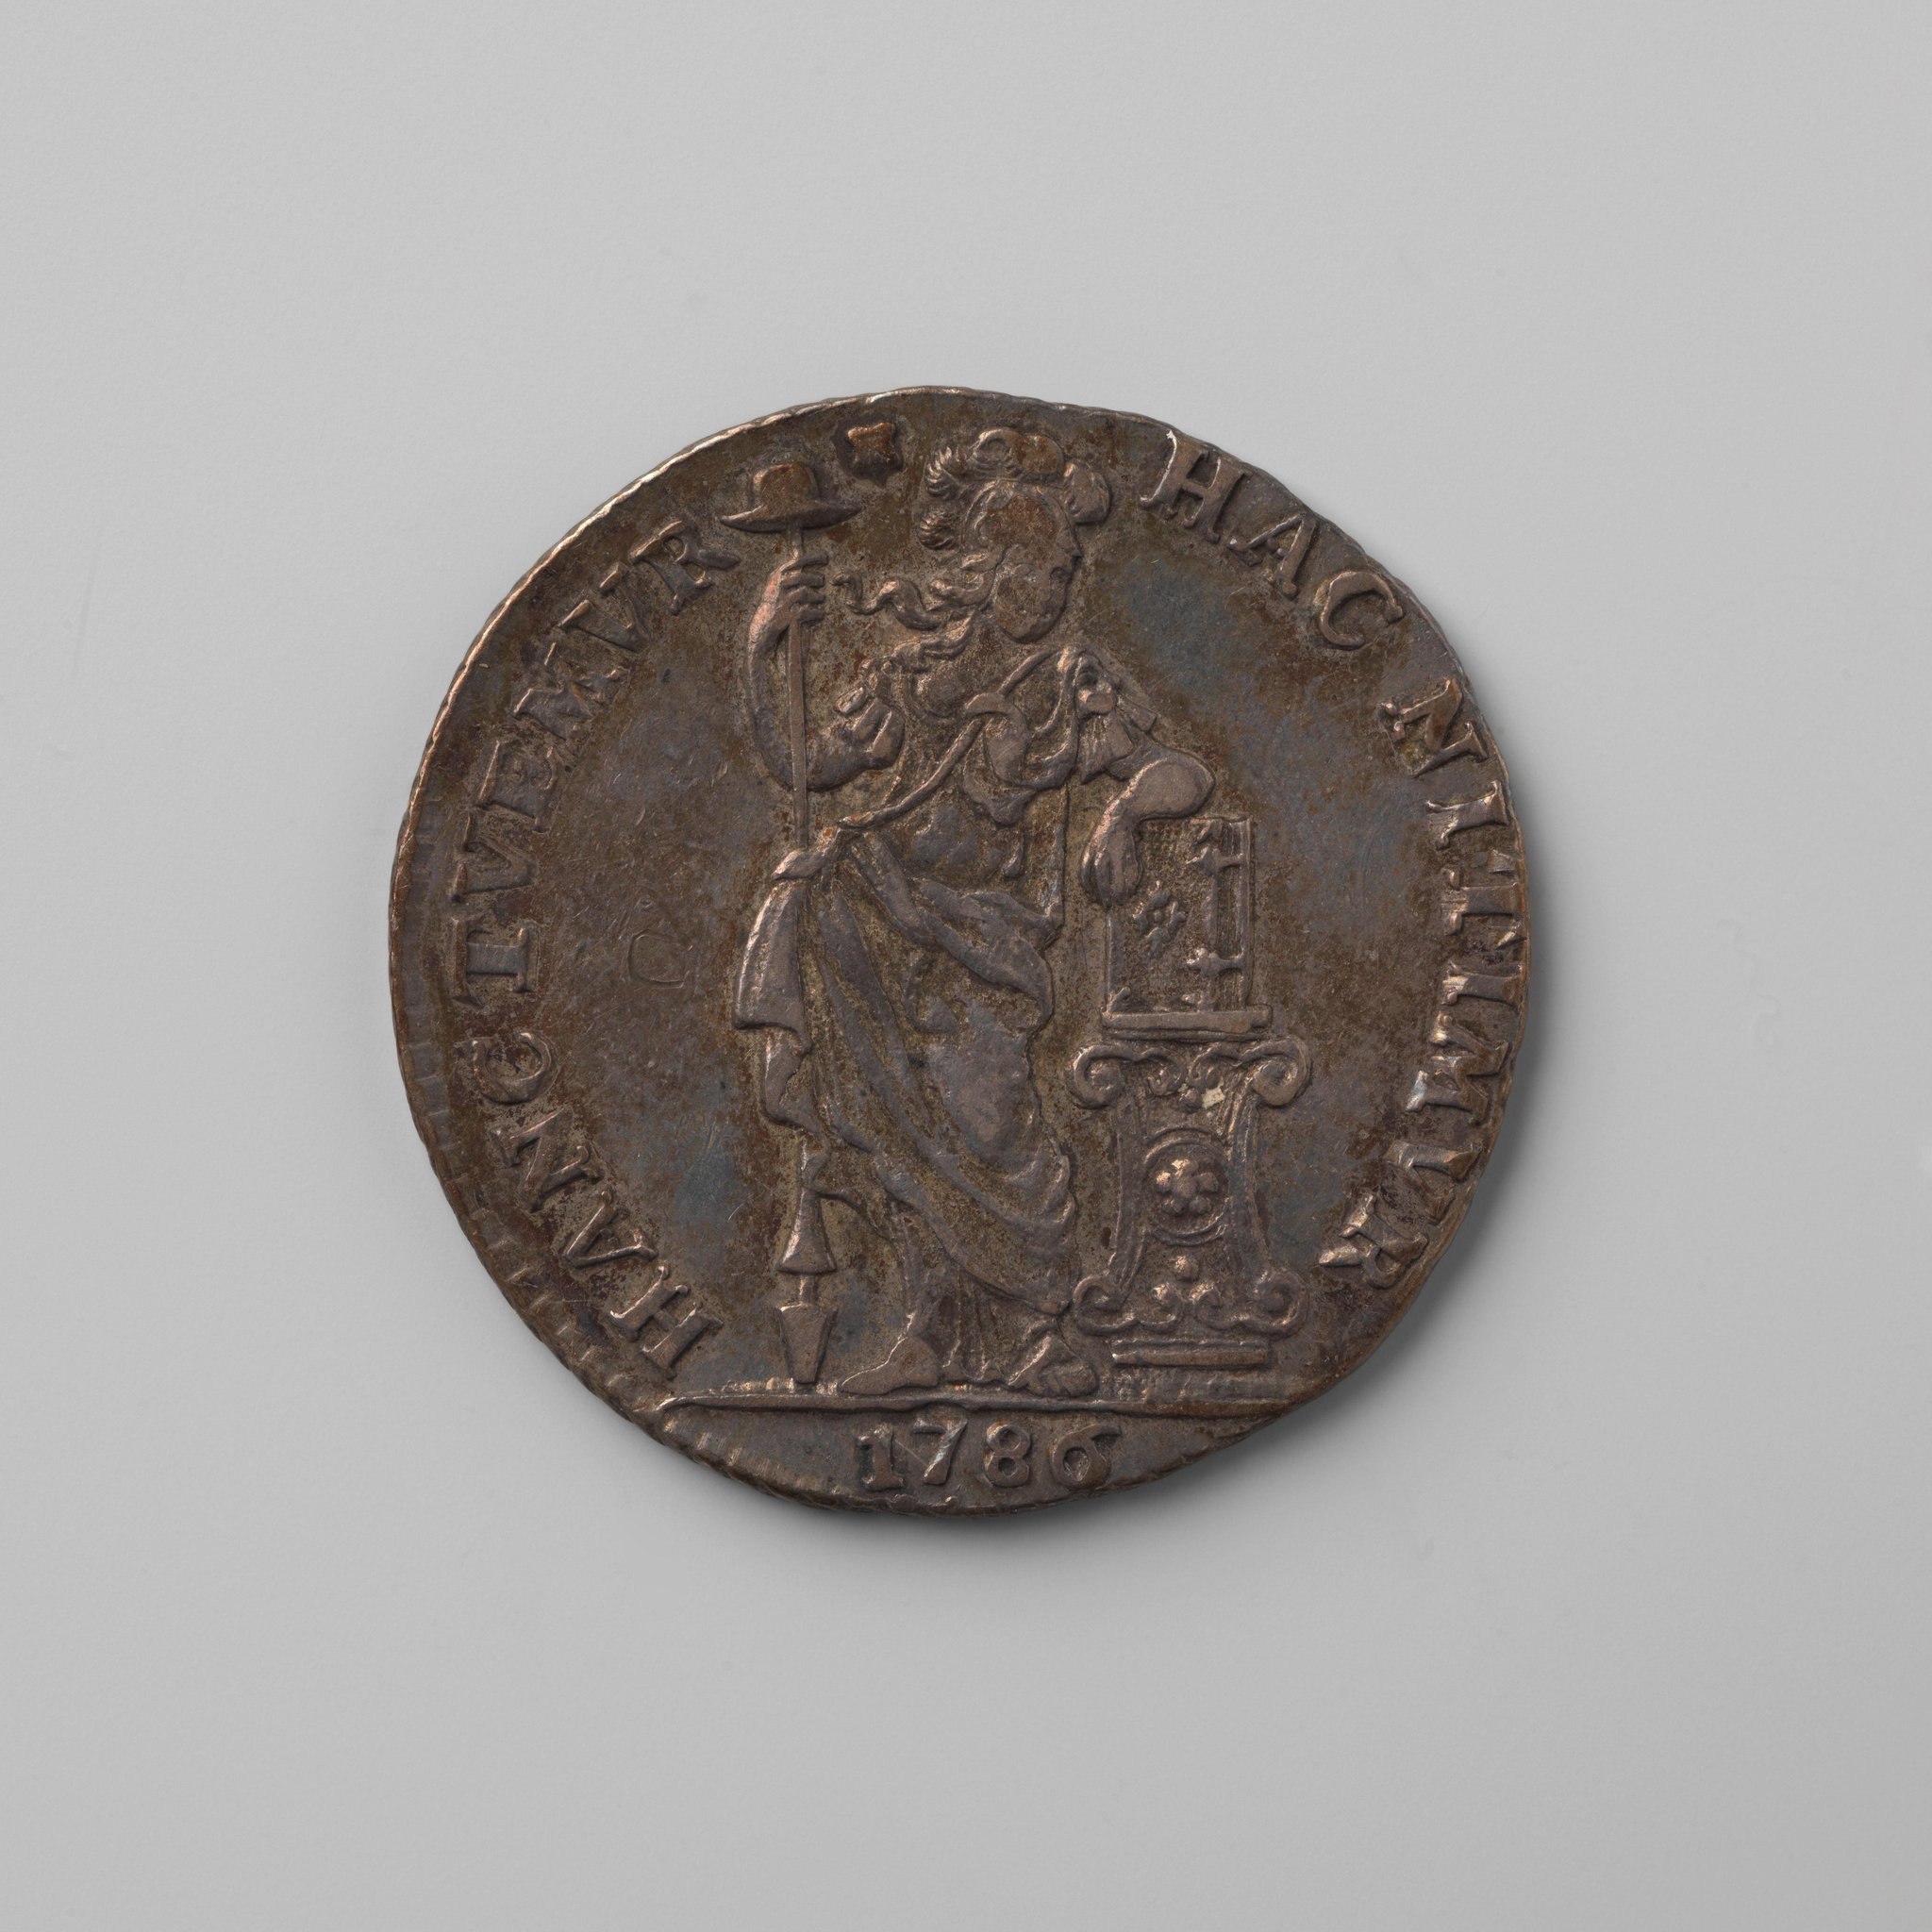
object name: coin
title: Gulden van de VOC uit Utrecht, 1786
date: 1786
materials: silver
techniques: striking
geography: utrecht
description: Zilveren munt. Voorzijde: tussen waarde-aanduiding 1 G gekroond generaliteitswapenschild, waaronder monogram van de VOC. Keerzijde: Nederlandse maagd met speer, waarop vrijheidshoed, leunend op een bijbel op een altaar. Jaartal in afsnede. Kabelrand.